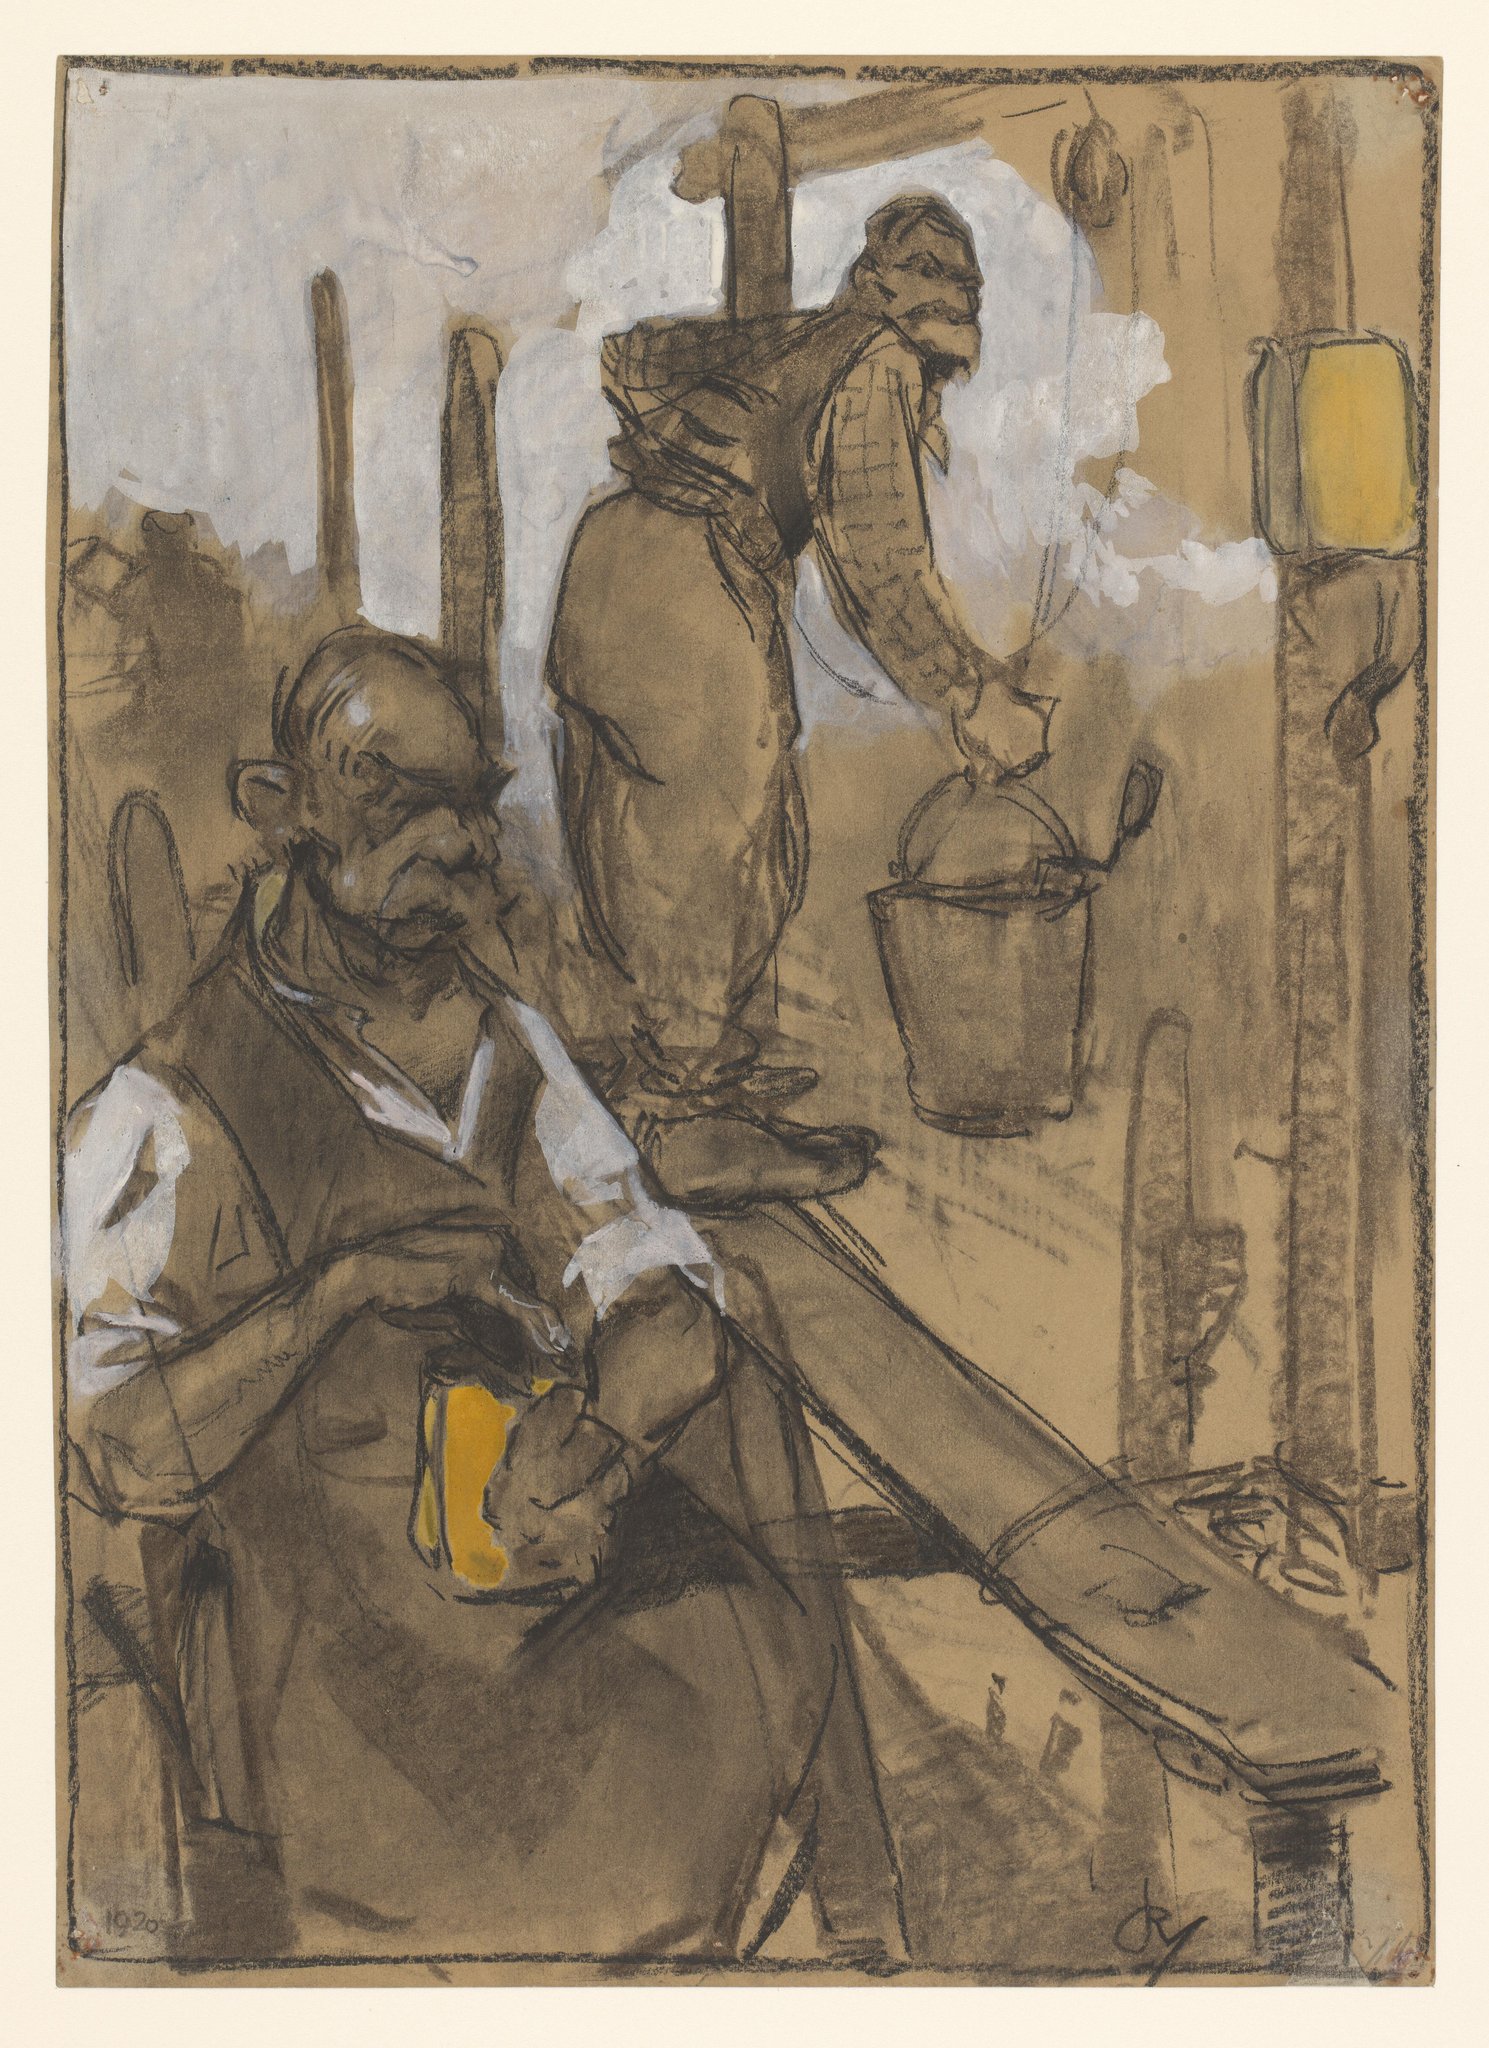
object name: drawing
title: Metselaars op een stelling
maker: dorus roovers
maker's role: draughtsman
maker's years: 1897-1953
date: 1920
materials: chalk, paint, paper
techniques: brush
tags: scaffold (~ building activities), brick-layer at work, building-site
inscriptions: date